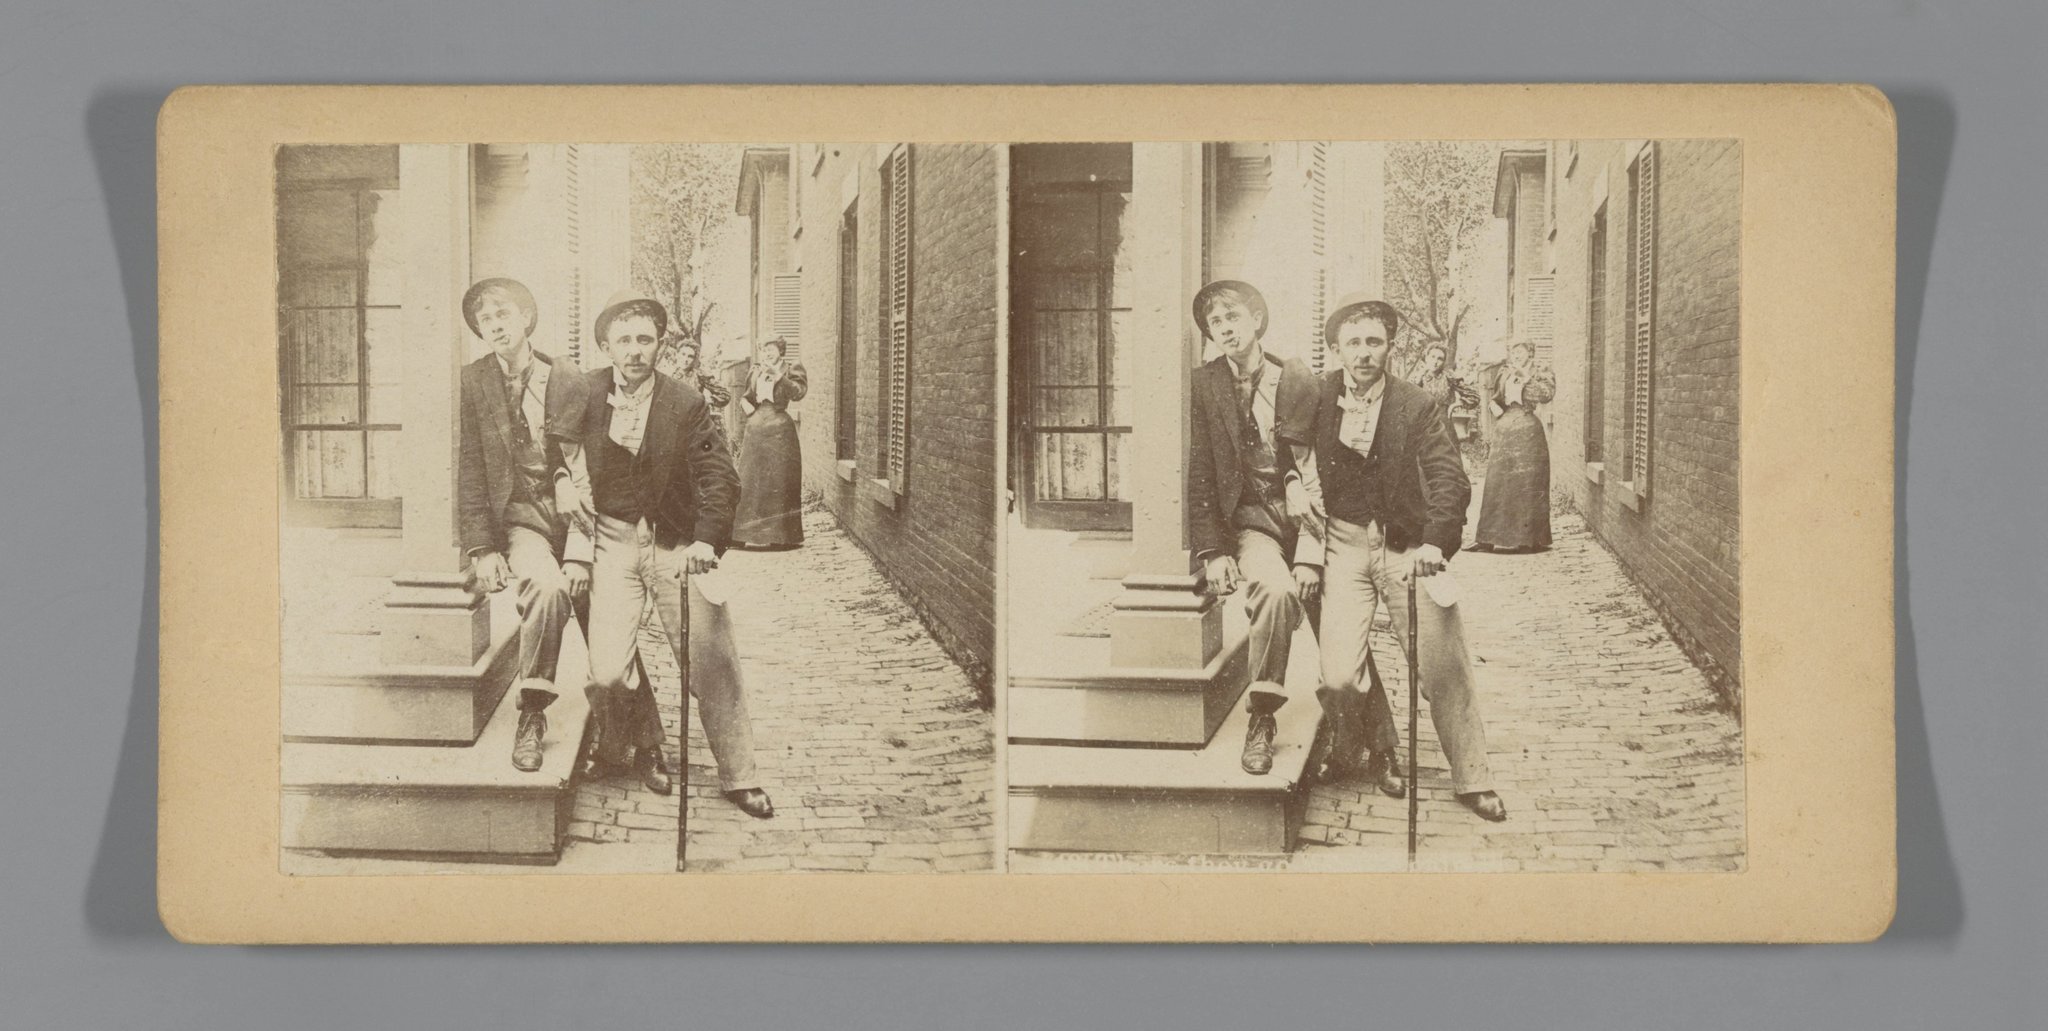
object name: stereograph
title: Twee mannen in een steeg met twee vrouwen op achtergrond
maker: Anonymous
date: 1895-1900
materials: cardboard, photographic support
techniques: gelatin silver print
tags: student life, lane, alley (+ city(-scape) with figures, staffage)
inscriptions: number: ‘50’, number: ‘30’